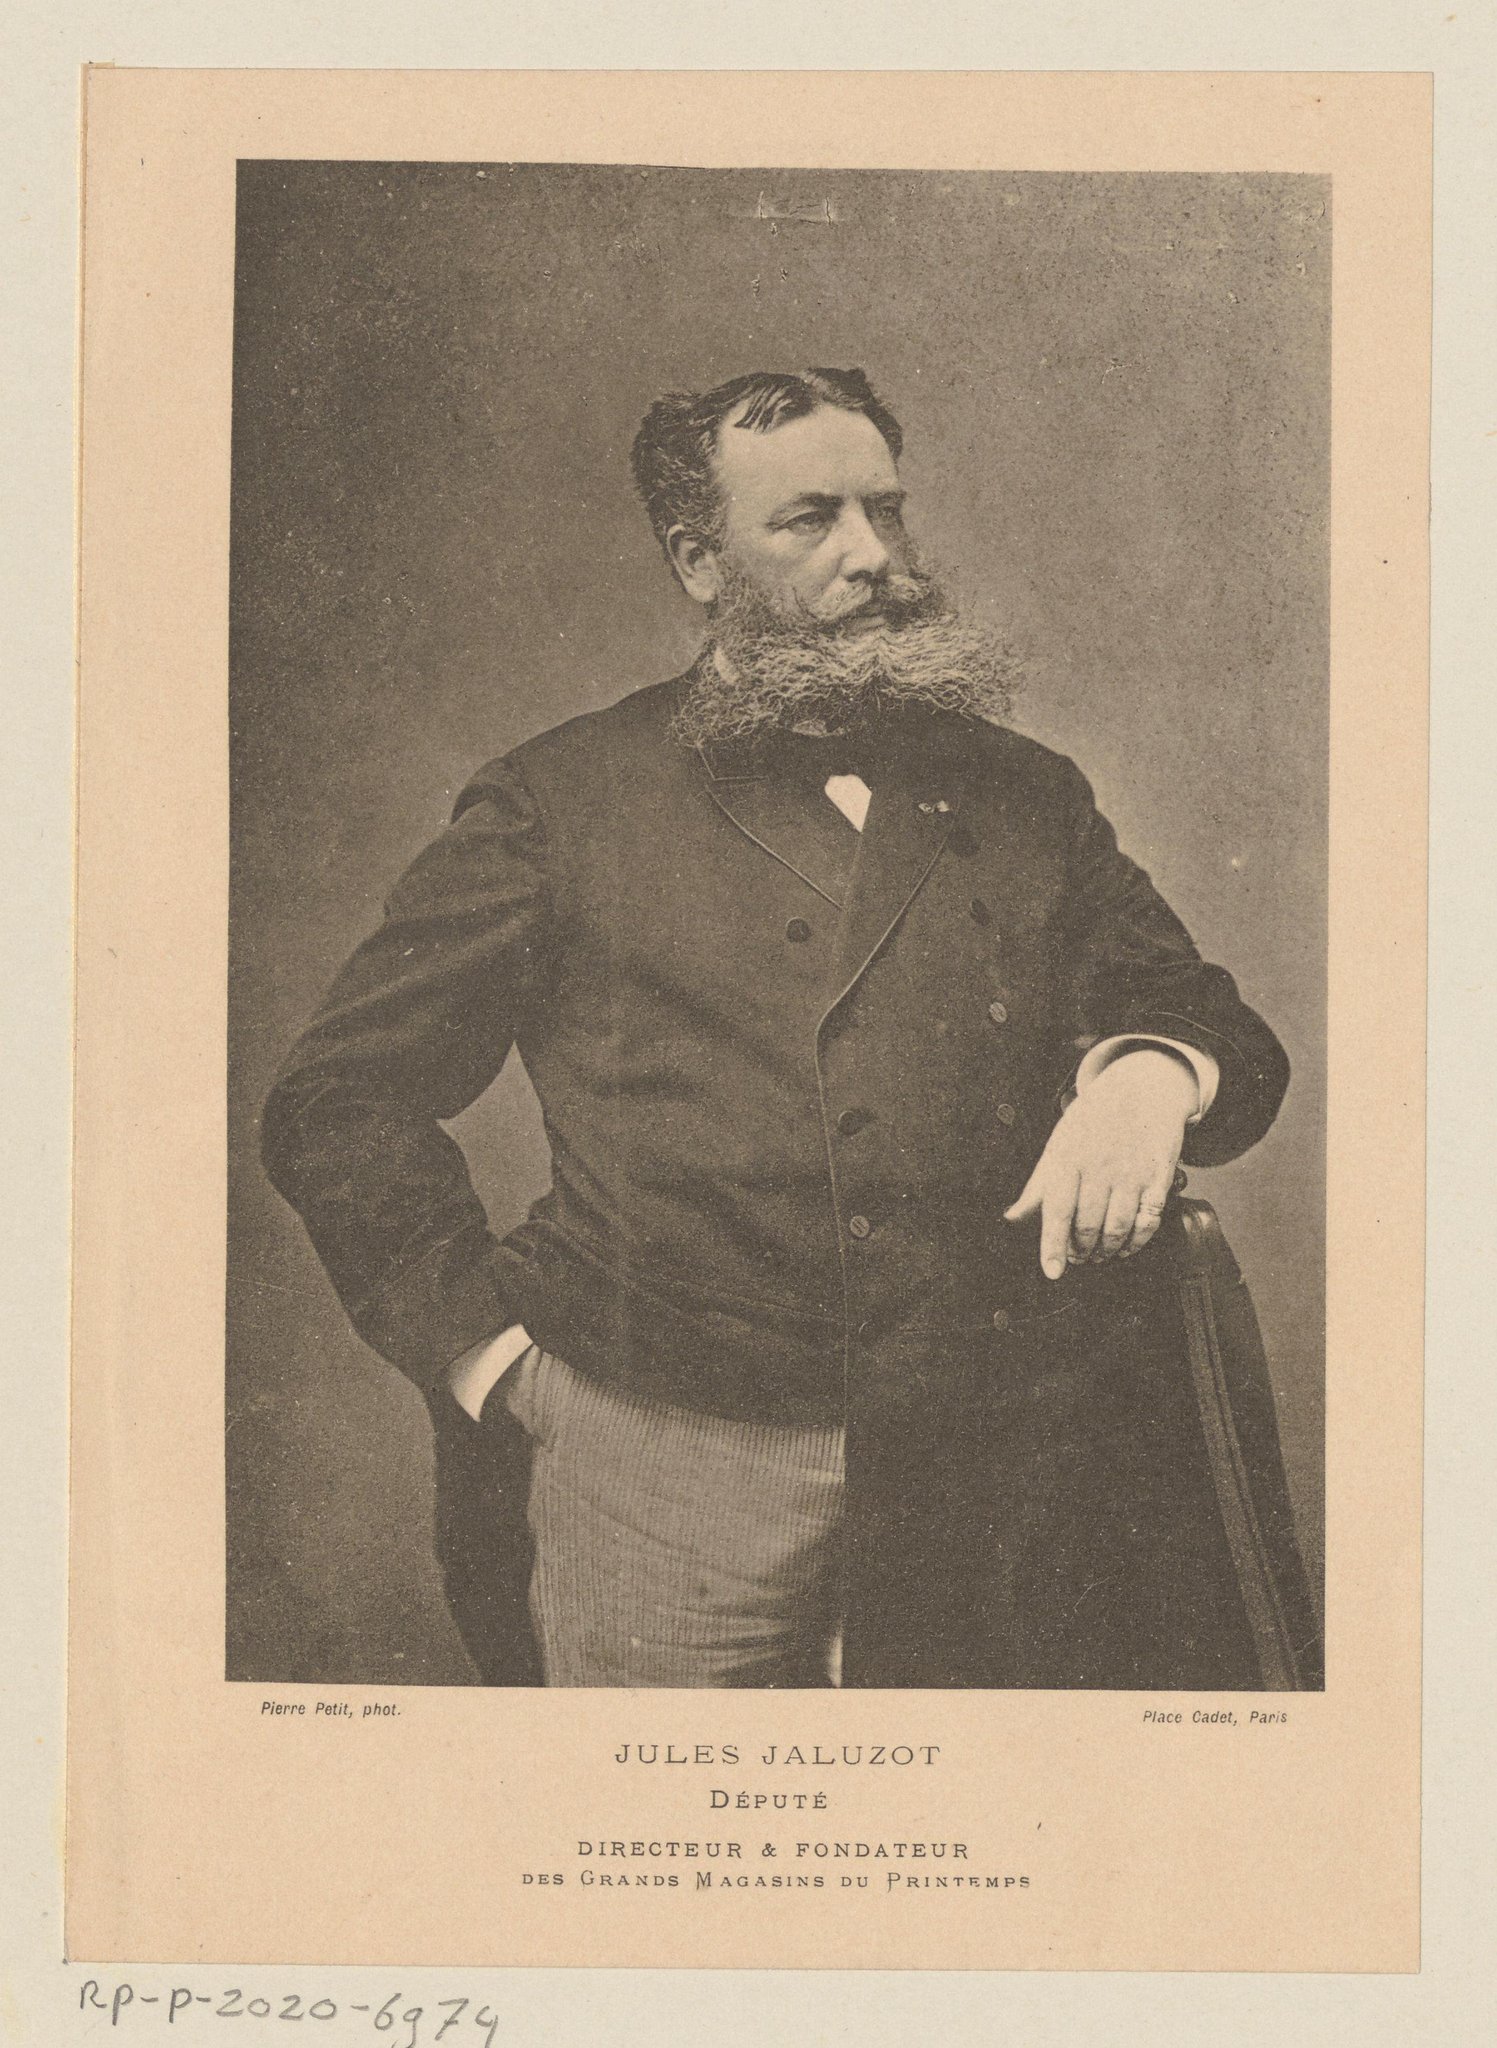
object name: photomechanical print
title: Portret van Jules Jaluzot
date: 1880-1916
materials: paper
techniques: photograph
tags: paris, politician, historical persons, politician, e.g. party leader